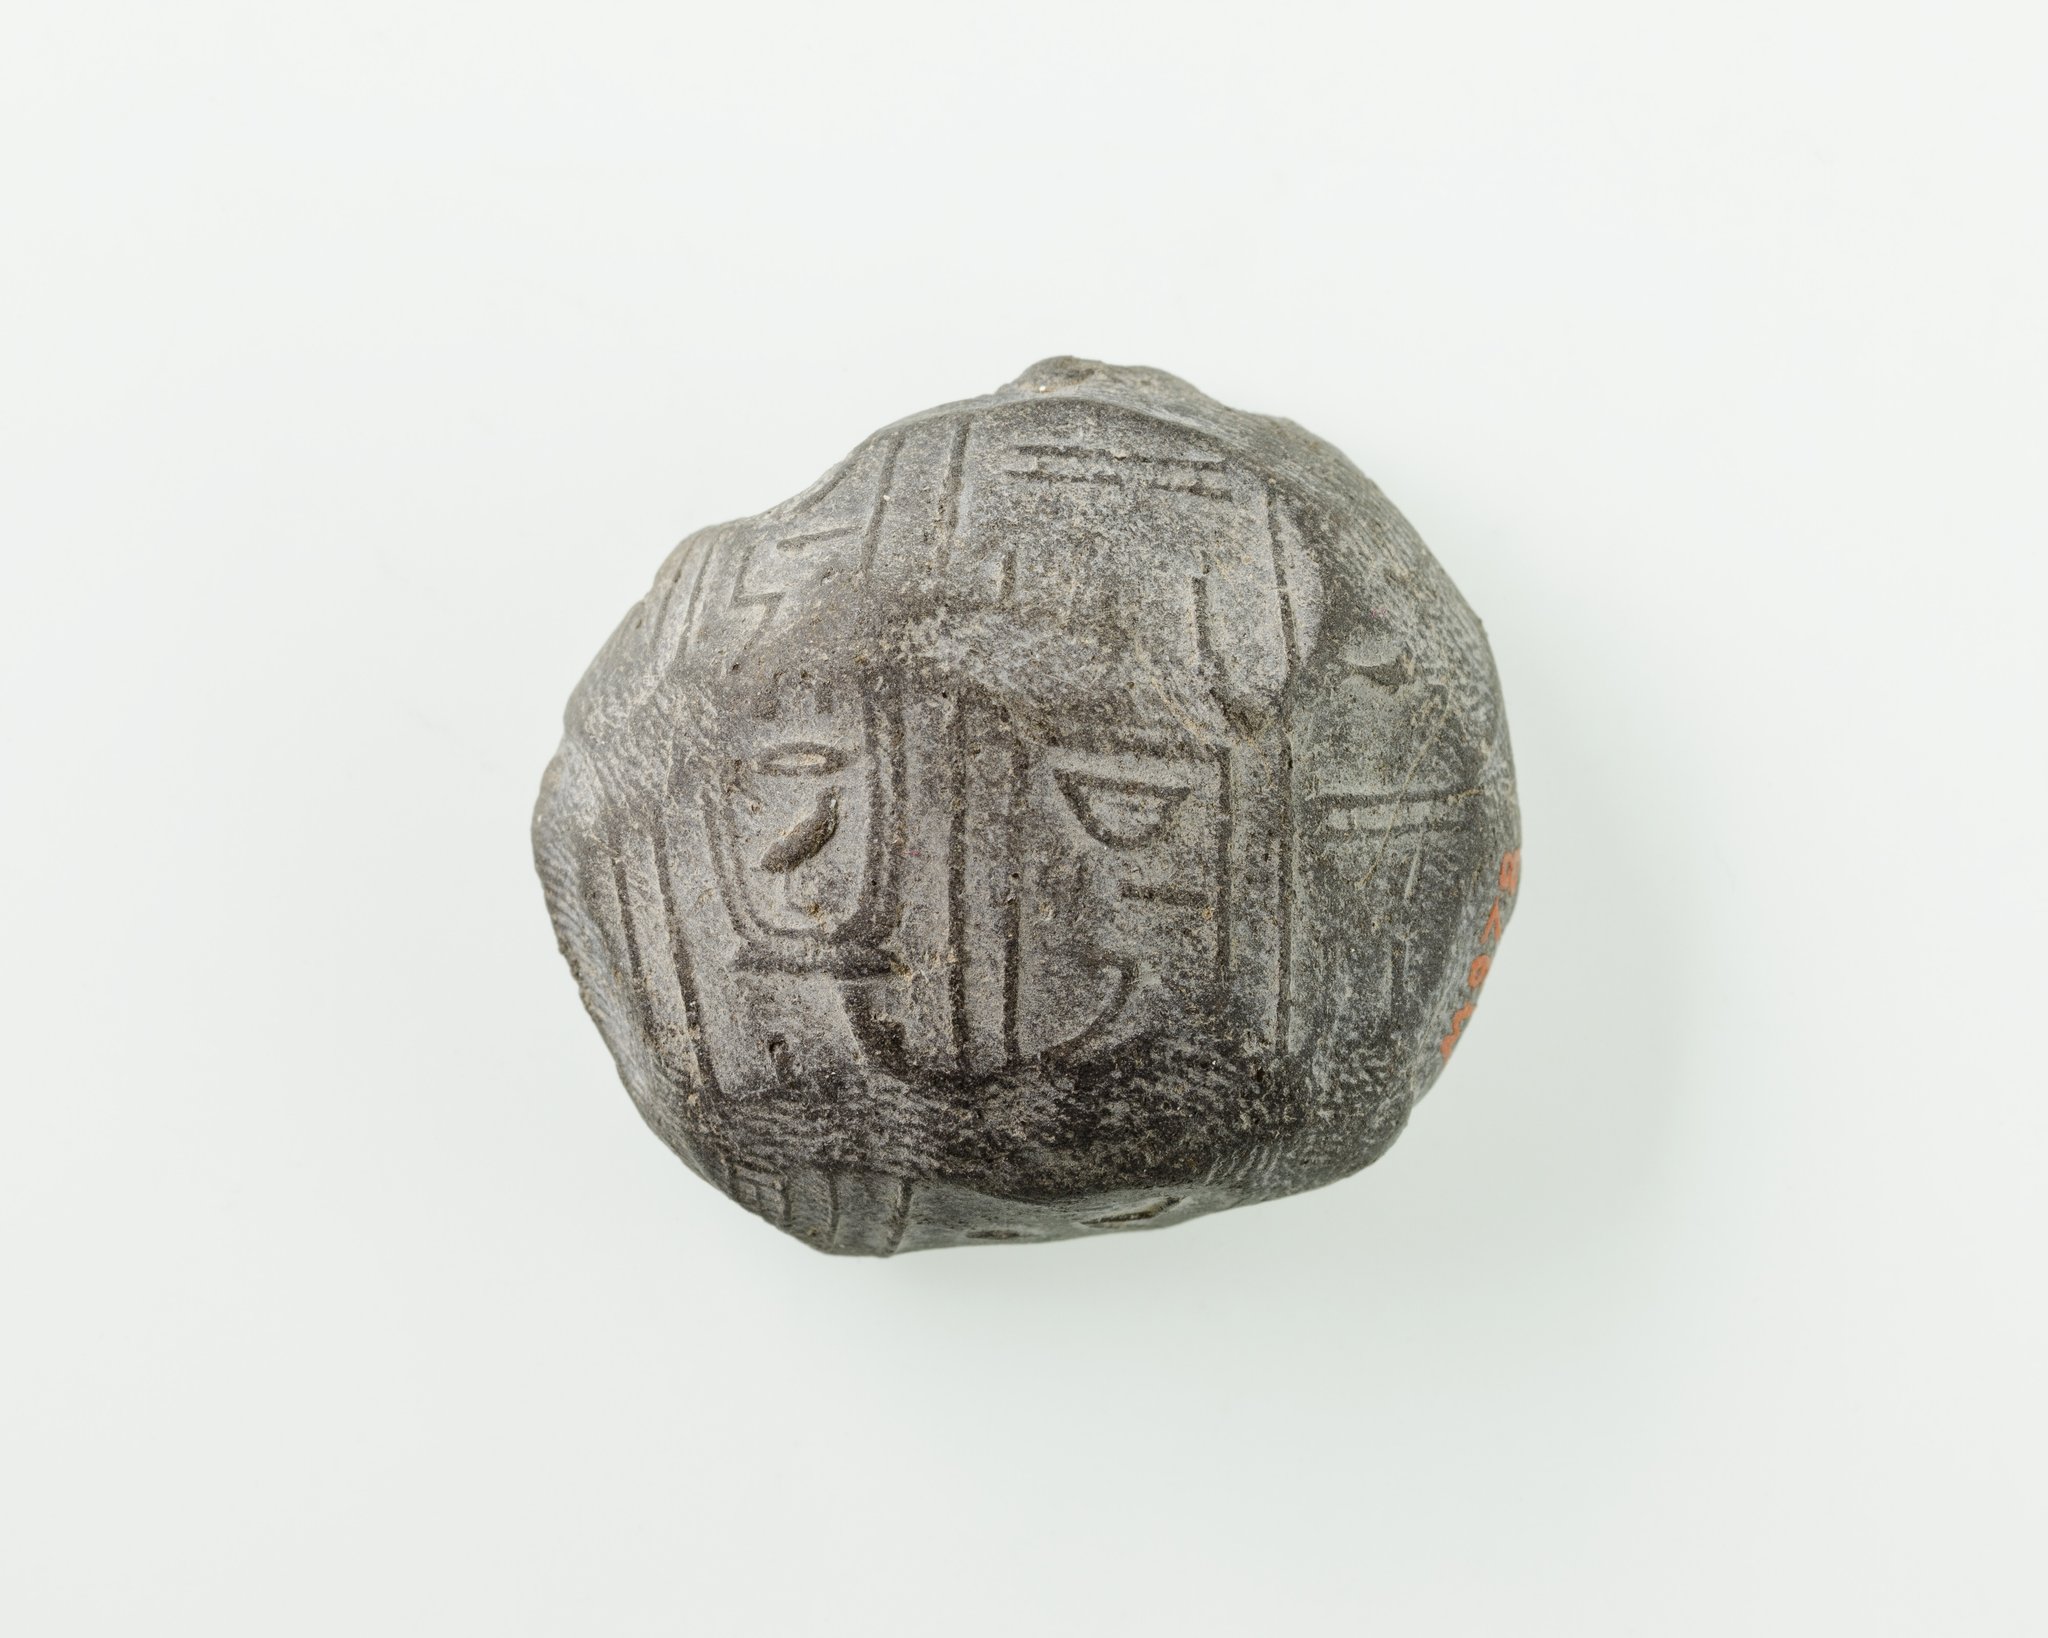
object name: sealing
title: Inscribed seal impression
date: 2649-2100 BCE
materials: clay, mud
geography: egypt